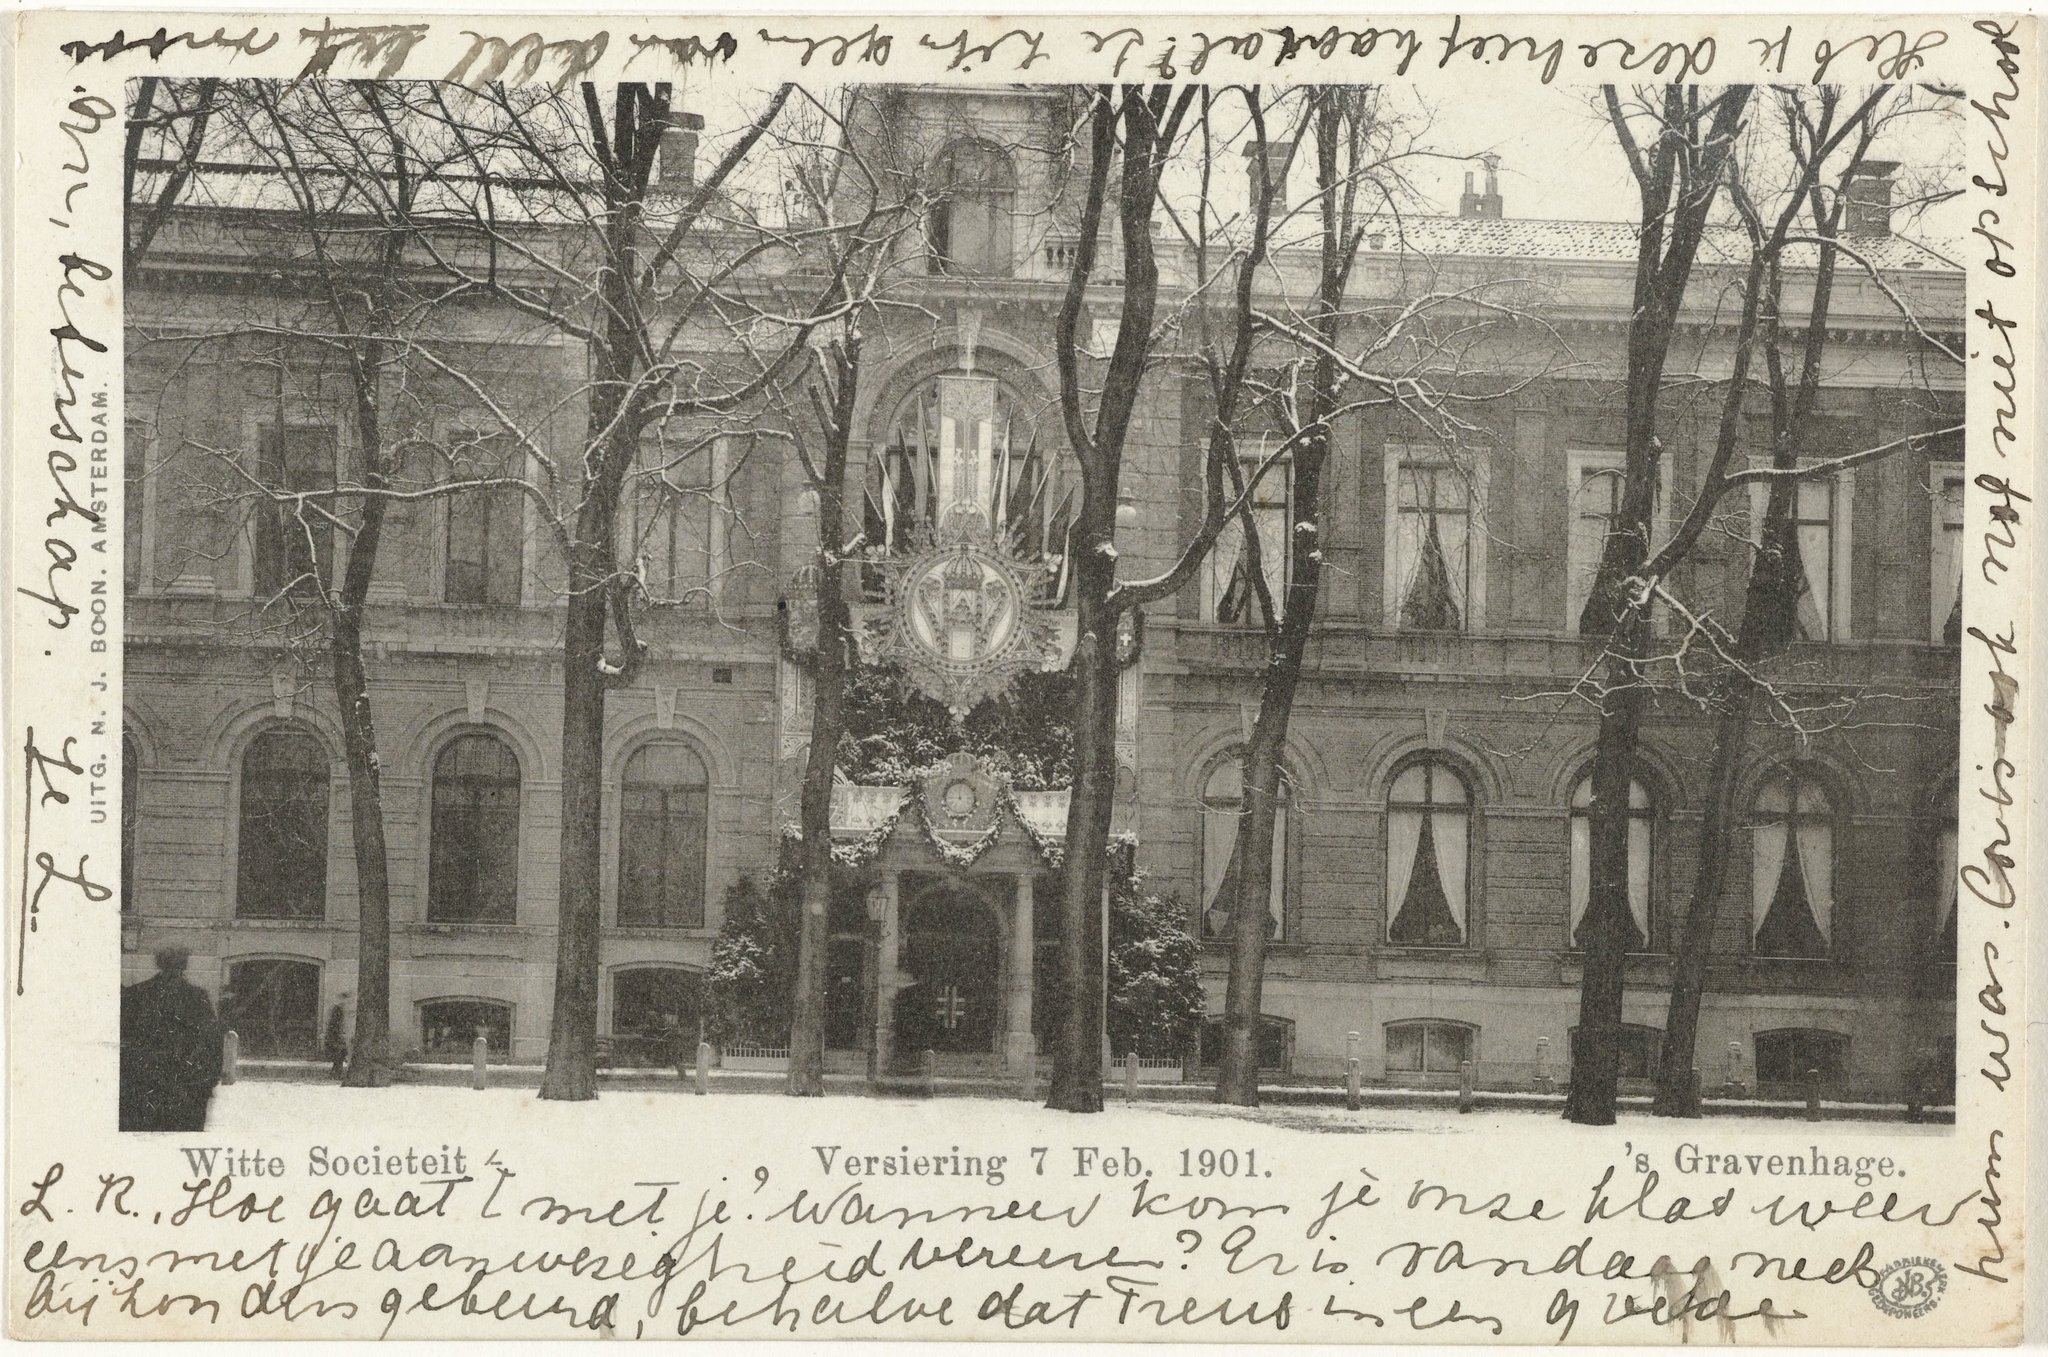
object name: ansichtkaart, prentbriefkaart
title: Versiering van Sociëteit De Witte bij het huwelijk van Wilhelmina, koningin der Nederlanden, en Hendrik van Mecklenburg-Schwerin te Den Haag op 7 februari 1901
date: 1901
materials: paper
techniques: photograph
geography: amsterdam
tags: print maker, wilhelmina of the netherlands, the hague, hendrik (prins der nederlanden (1876-1934)), (civil) marriage ceremonies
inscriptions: inscription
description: De hier vermelde titel verwijst naar de hoogst verkregen titel van de geportretteerde, niet per se naar de titel die de geportretteerde op deze voorstelling draagt.